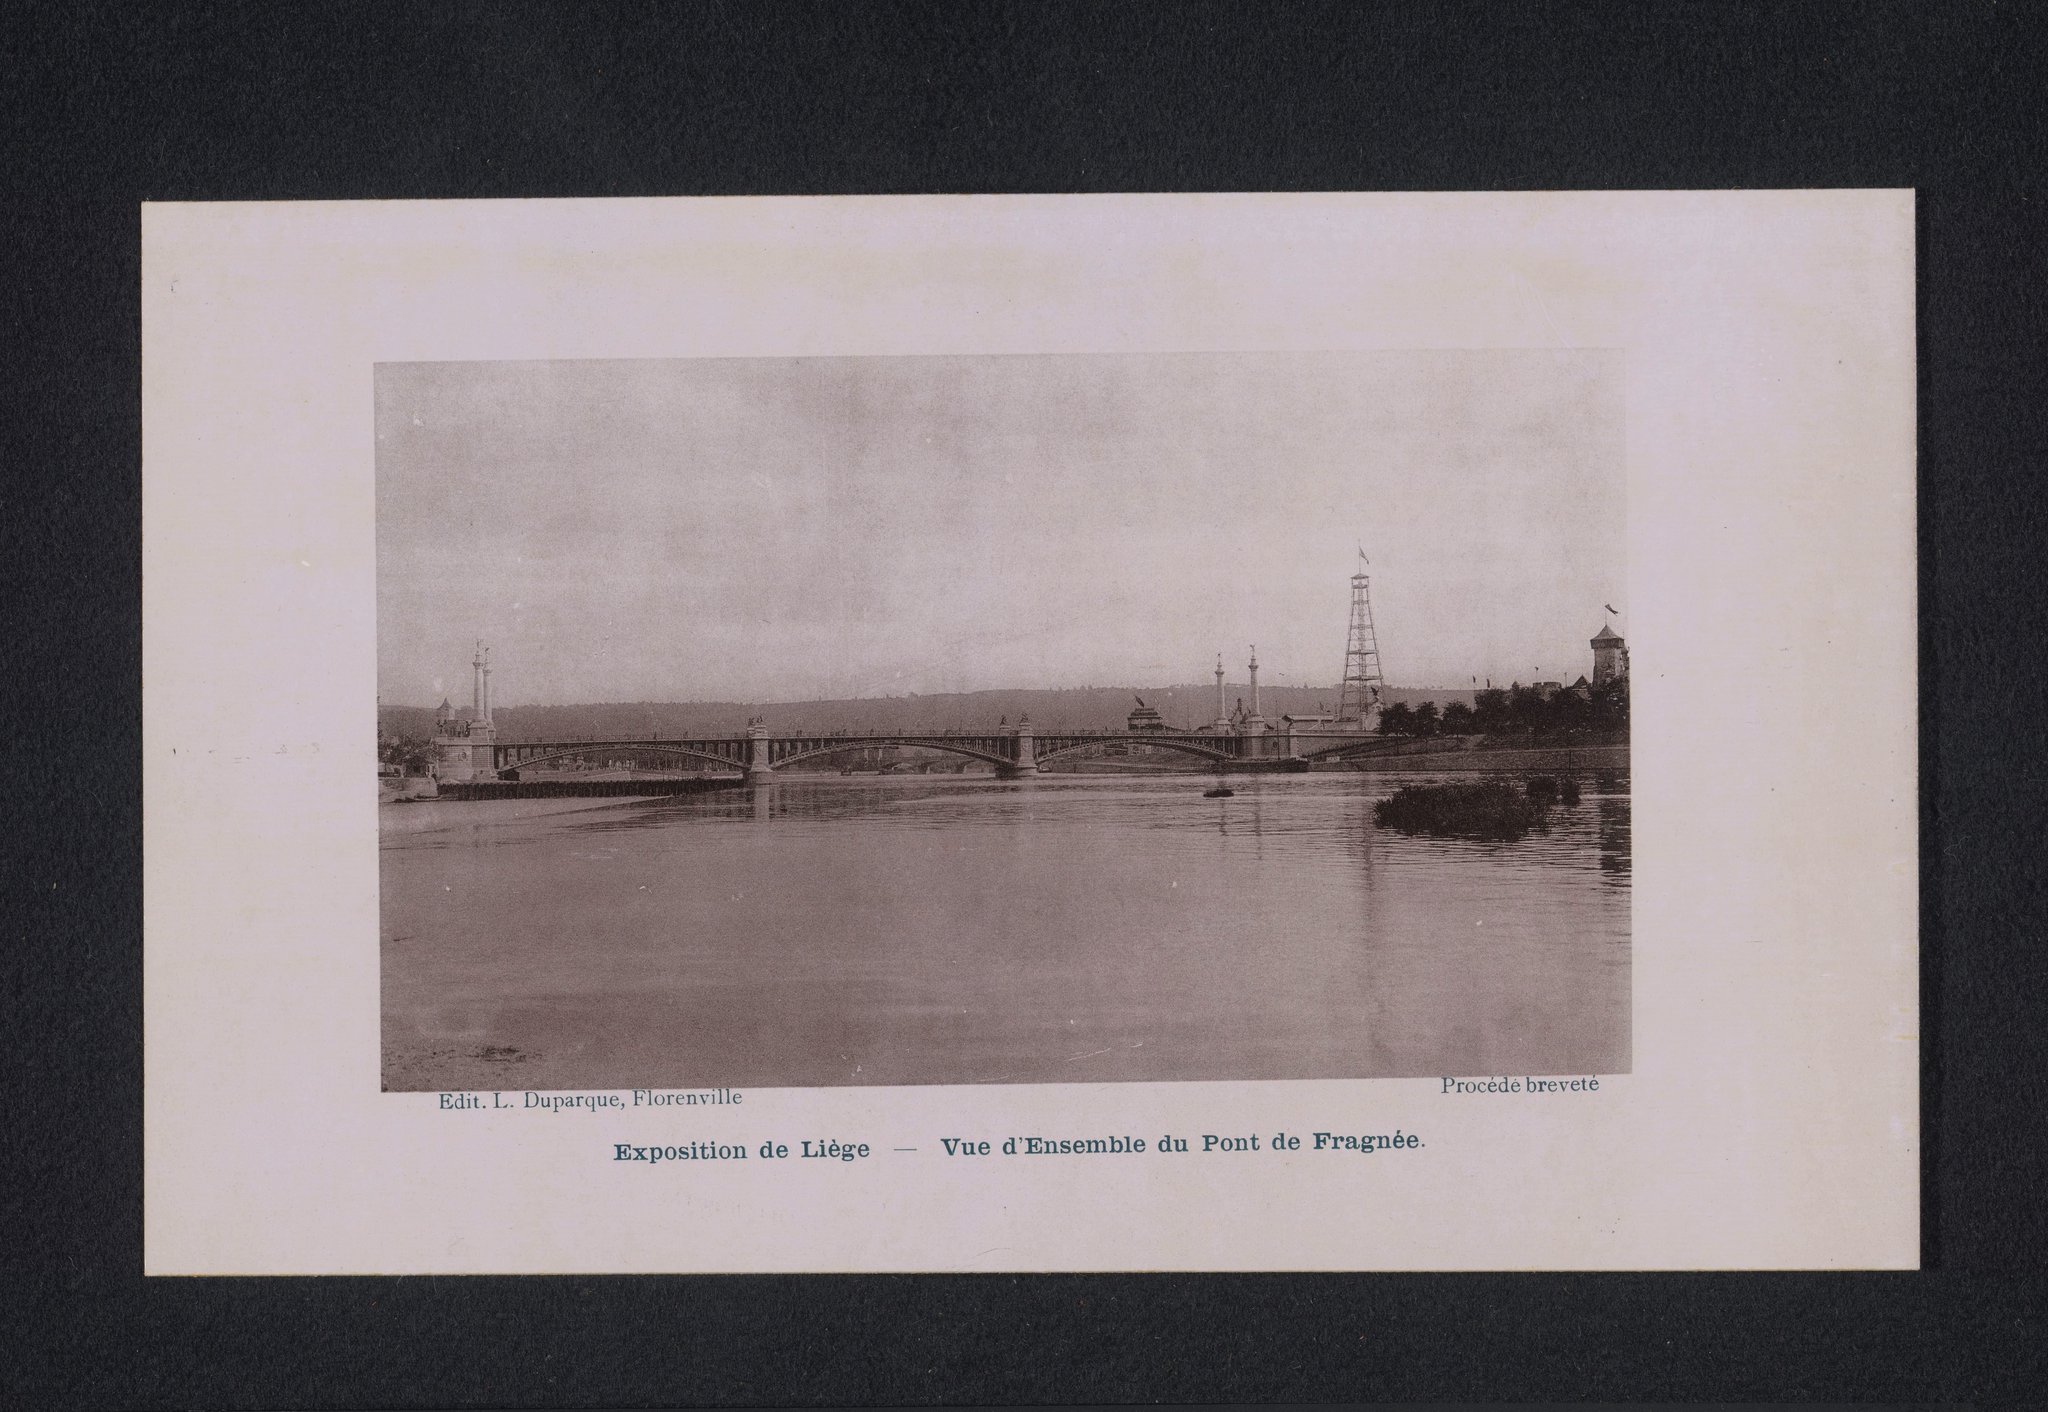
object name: photomechanical print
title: Gezicht op de Pont de Fragnée, ingang van de Wereldtentoonstelling van 1905 in Luik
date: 1905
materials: paper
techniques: photograph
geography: florenville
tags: world fair, world exhibition, bridge, liège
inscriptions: inscription: ‘Procédé breveté’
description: Deze prent maakt deel uit van een omslag met 16 prenten.